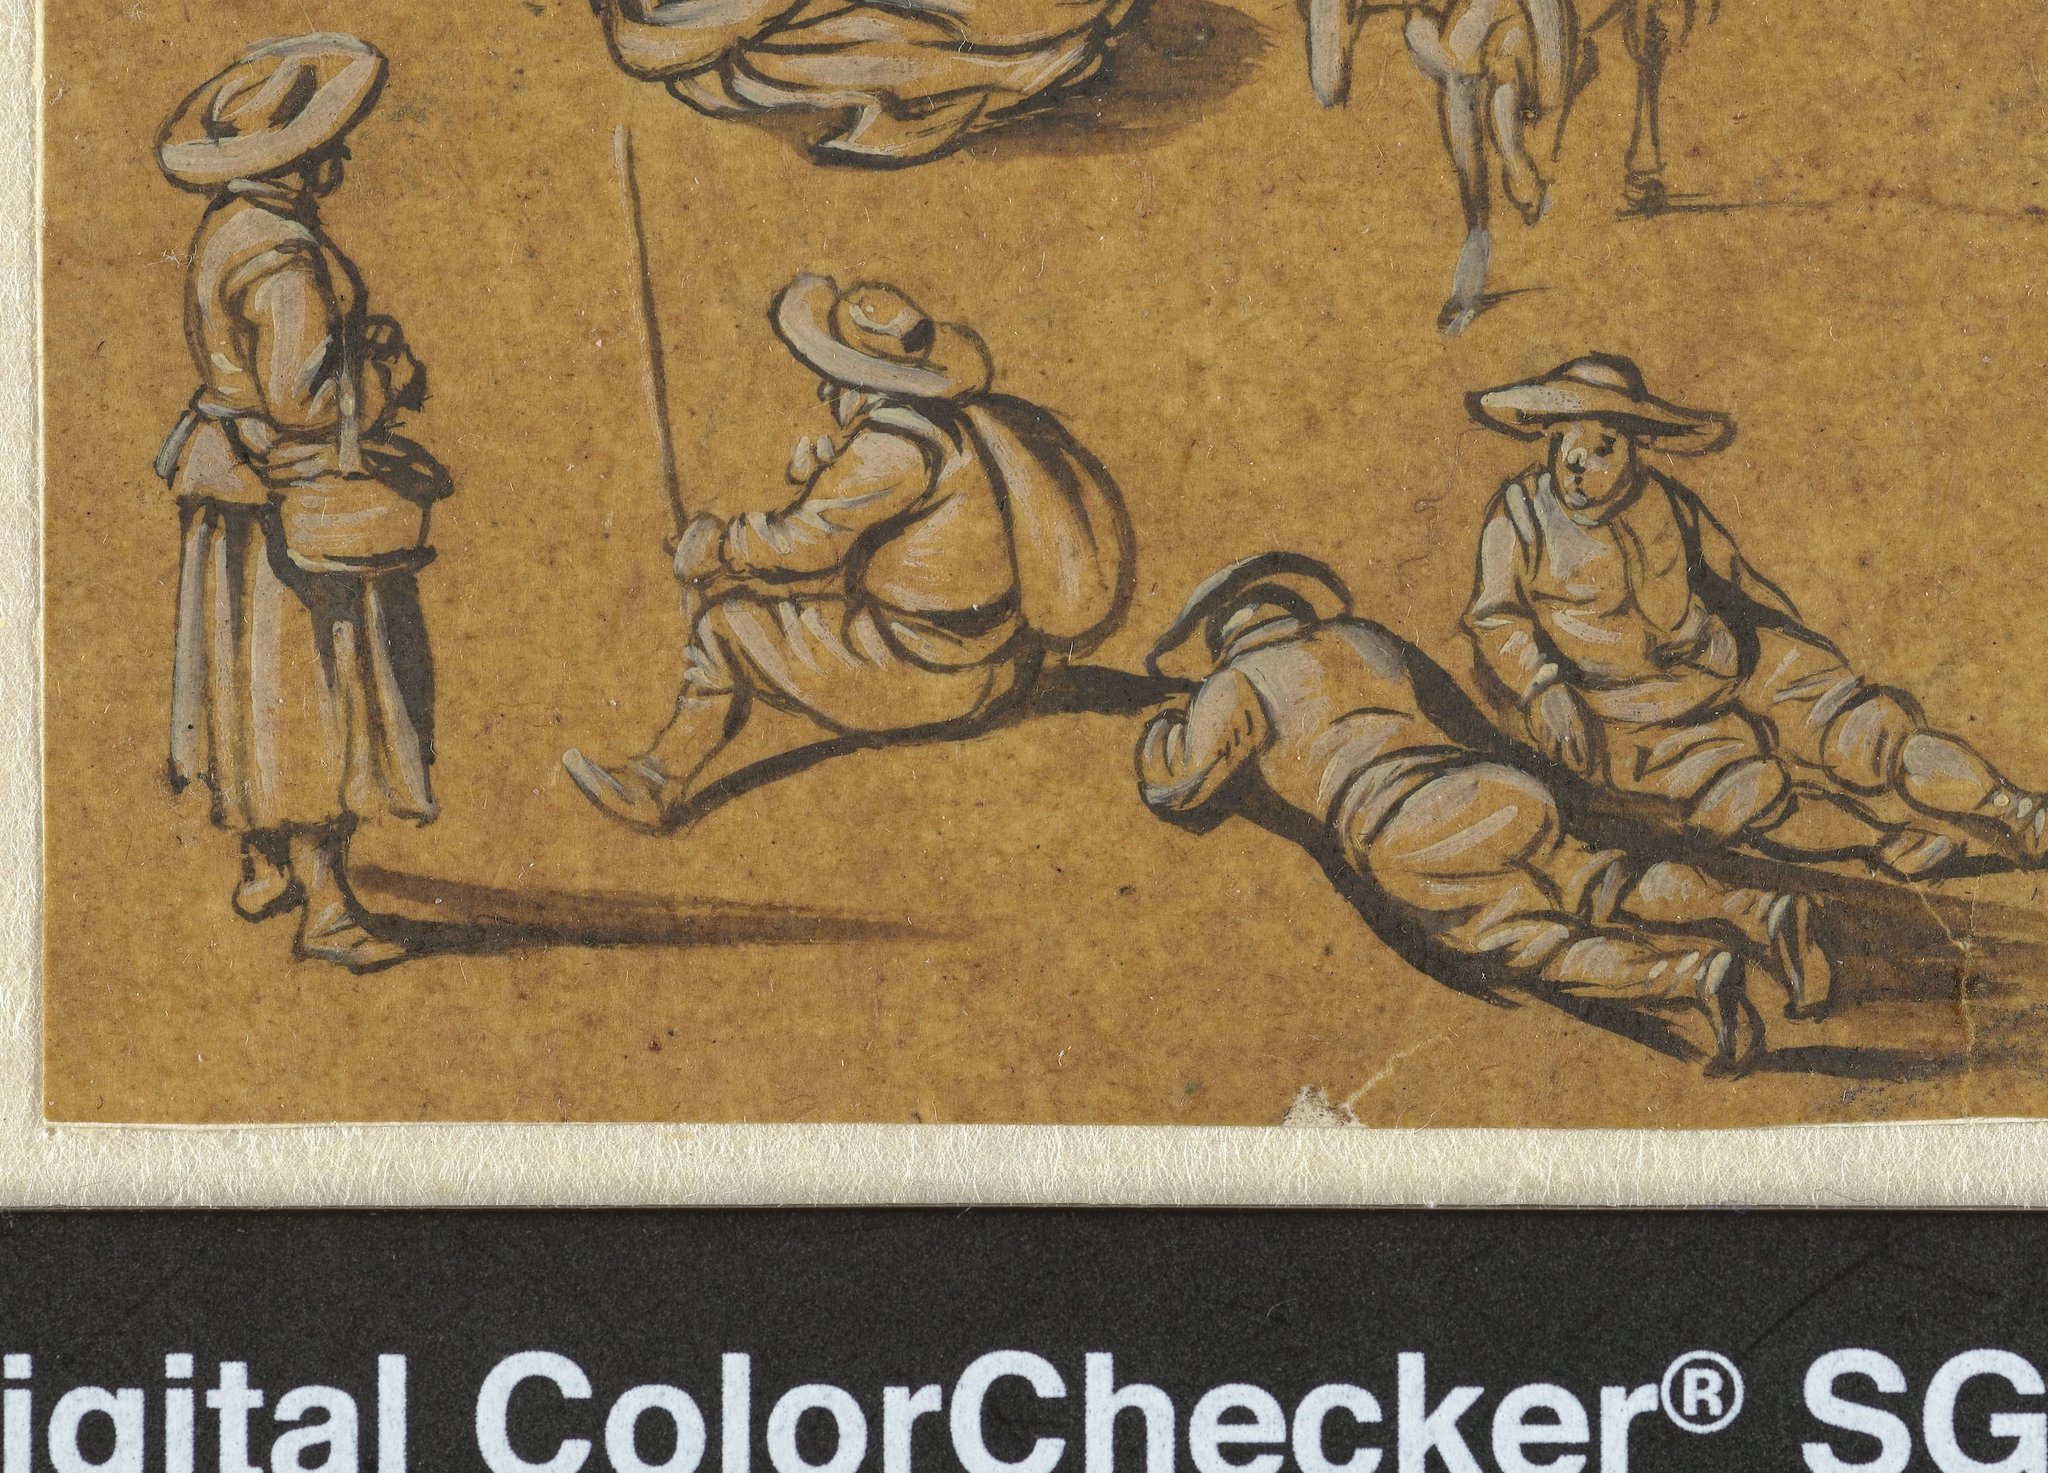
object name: drawing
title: Studieblad met zes verschillende figuurtjes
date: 1600-1680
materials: paint, paper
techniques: brush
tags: female sex; woman, male sex; man